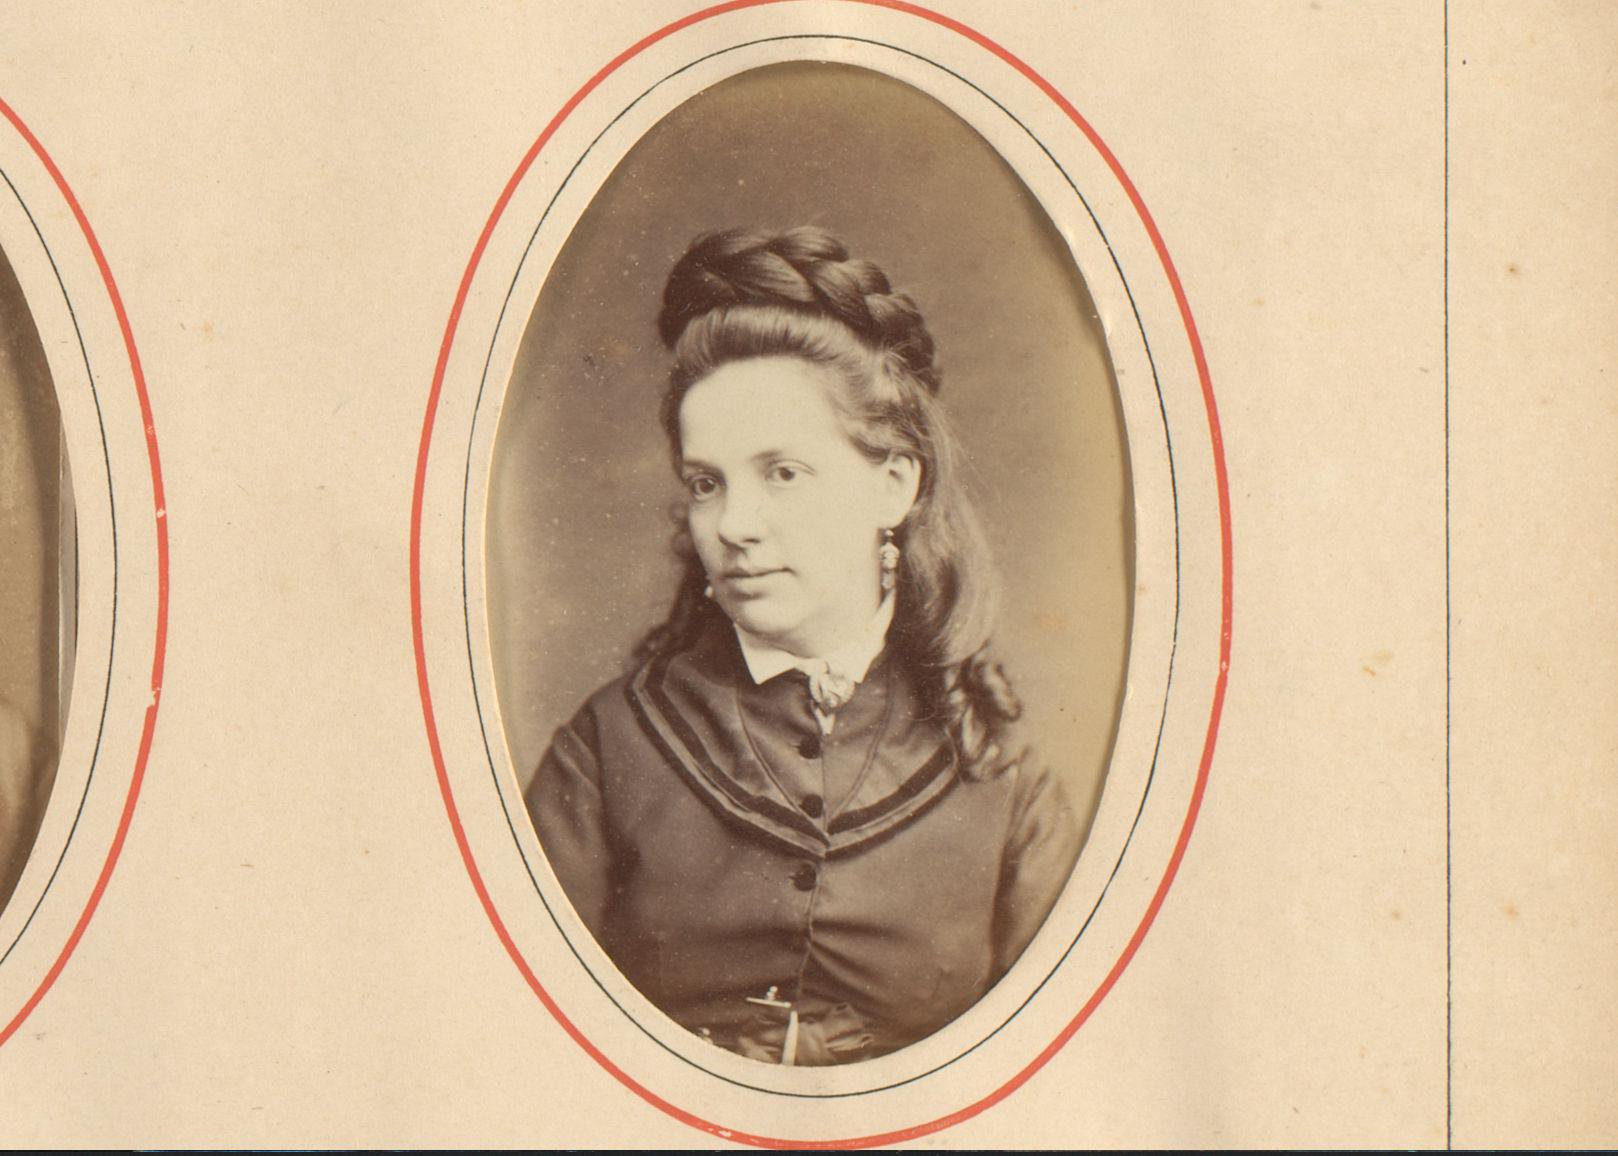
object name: album leaf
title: Portret van een onbekende vrouw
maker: albert greiner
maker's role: fotograaf, fotostudio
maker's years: 1833-1890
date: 1870-1874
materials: cardboard, paper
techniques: albumen print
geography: amsterdam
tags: anonymous historical person portrayed - bb - woman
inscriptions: address: ‘NIEUWENDIJK L. 87/ AMSTERDAM’